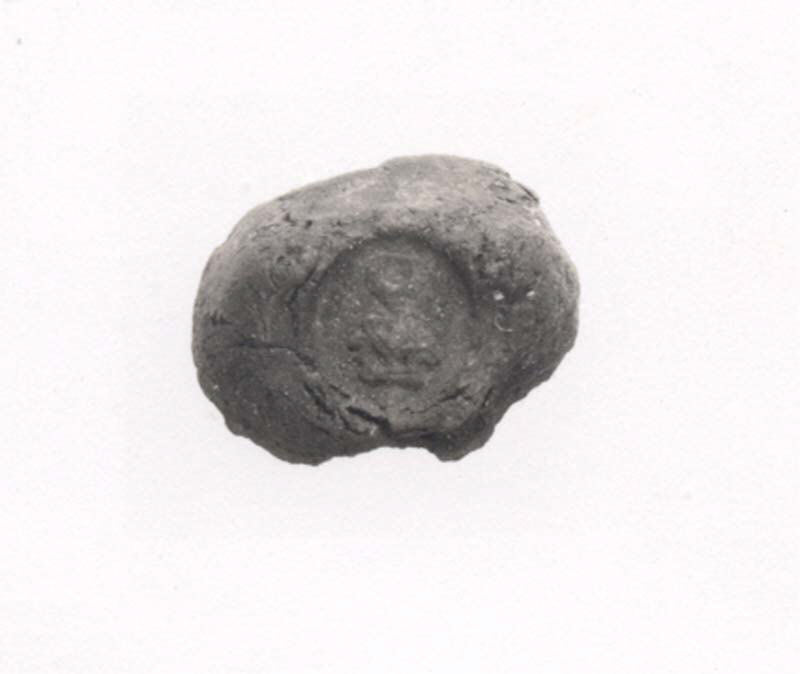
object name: sealing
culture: sasanian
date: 601-700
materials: clay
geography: iran